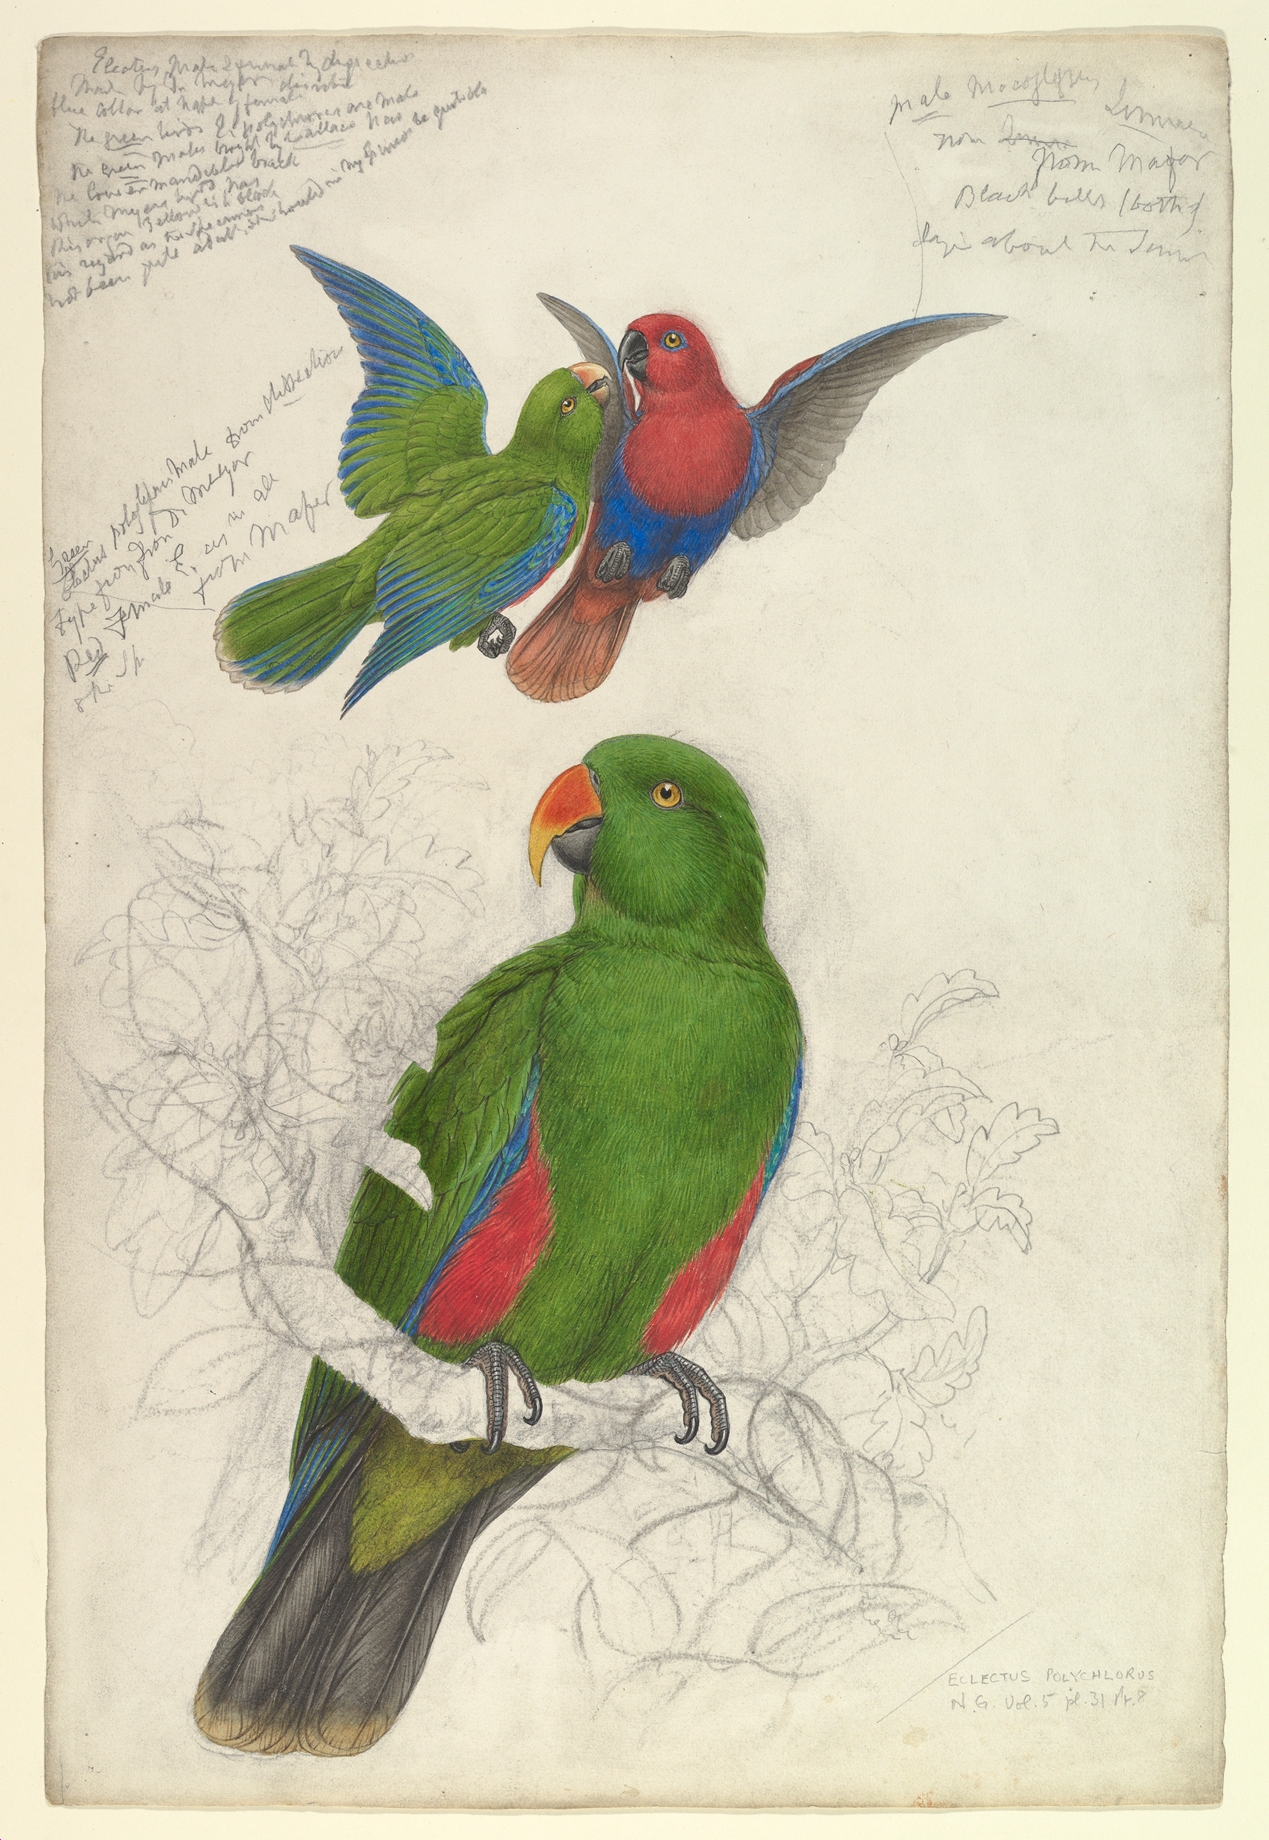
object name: drawing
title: Eclectus Roratus Polychloros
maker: edward lear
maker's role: artist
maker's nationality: british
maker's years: 1812-1888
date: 1830-1832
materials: chalk, gouache, graphite, watercolor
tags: parrots